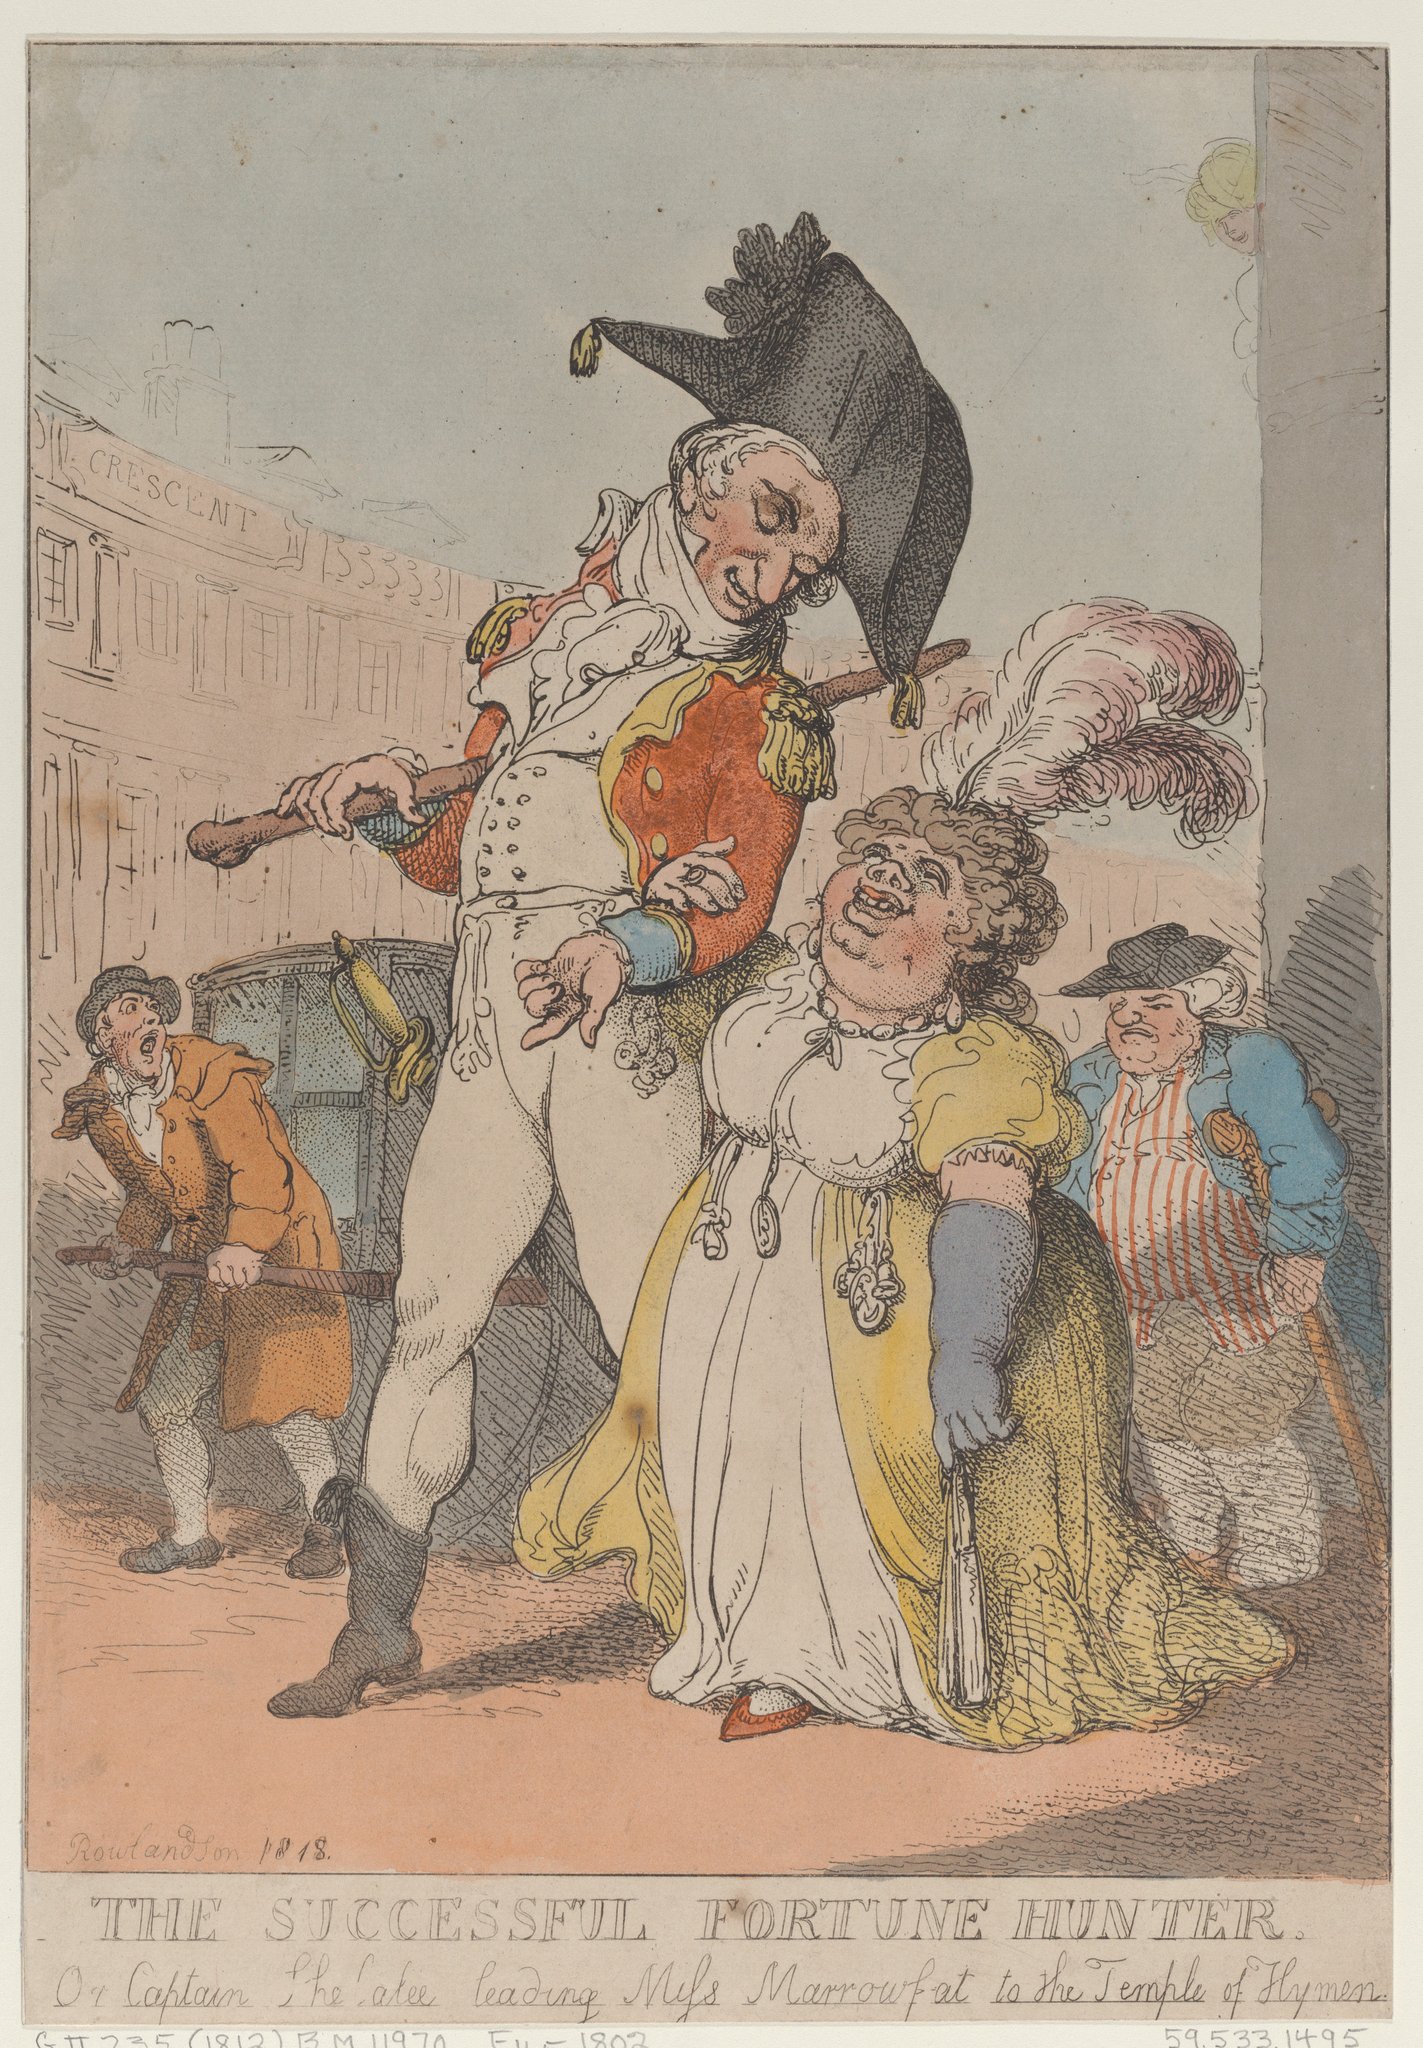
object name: print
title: The Successful Fortune Hunter, or Captain Shelalee Leading Miss Marrowfat to the Temple of Hymen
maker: thomas rowlandson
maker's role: artist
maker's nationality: british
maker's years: 1757-1827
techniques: etching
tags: satire,men,women